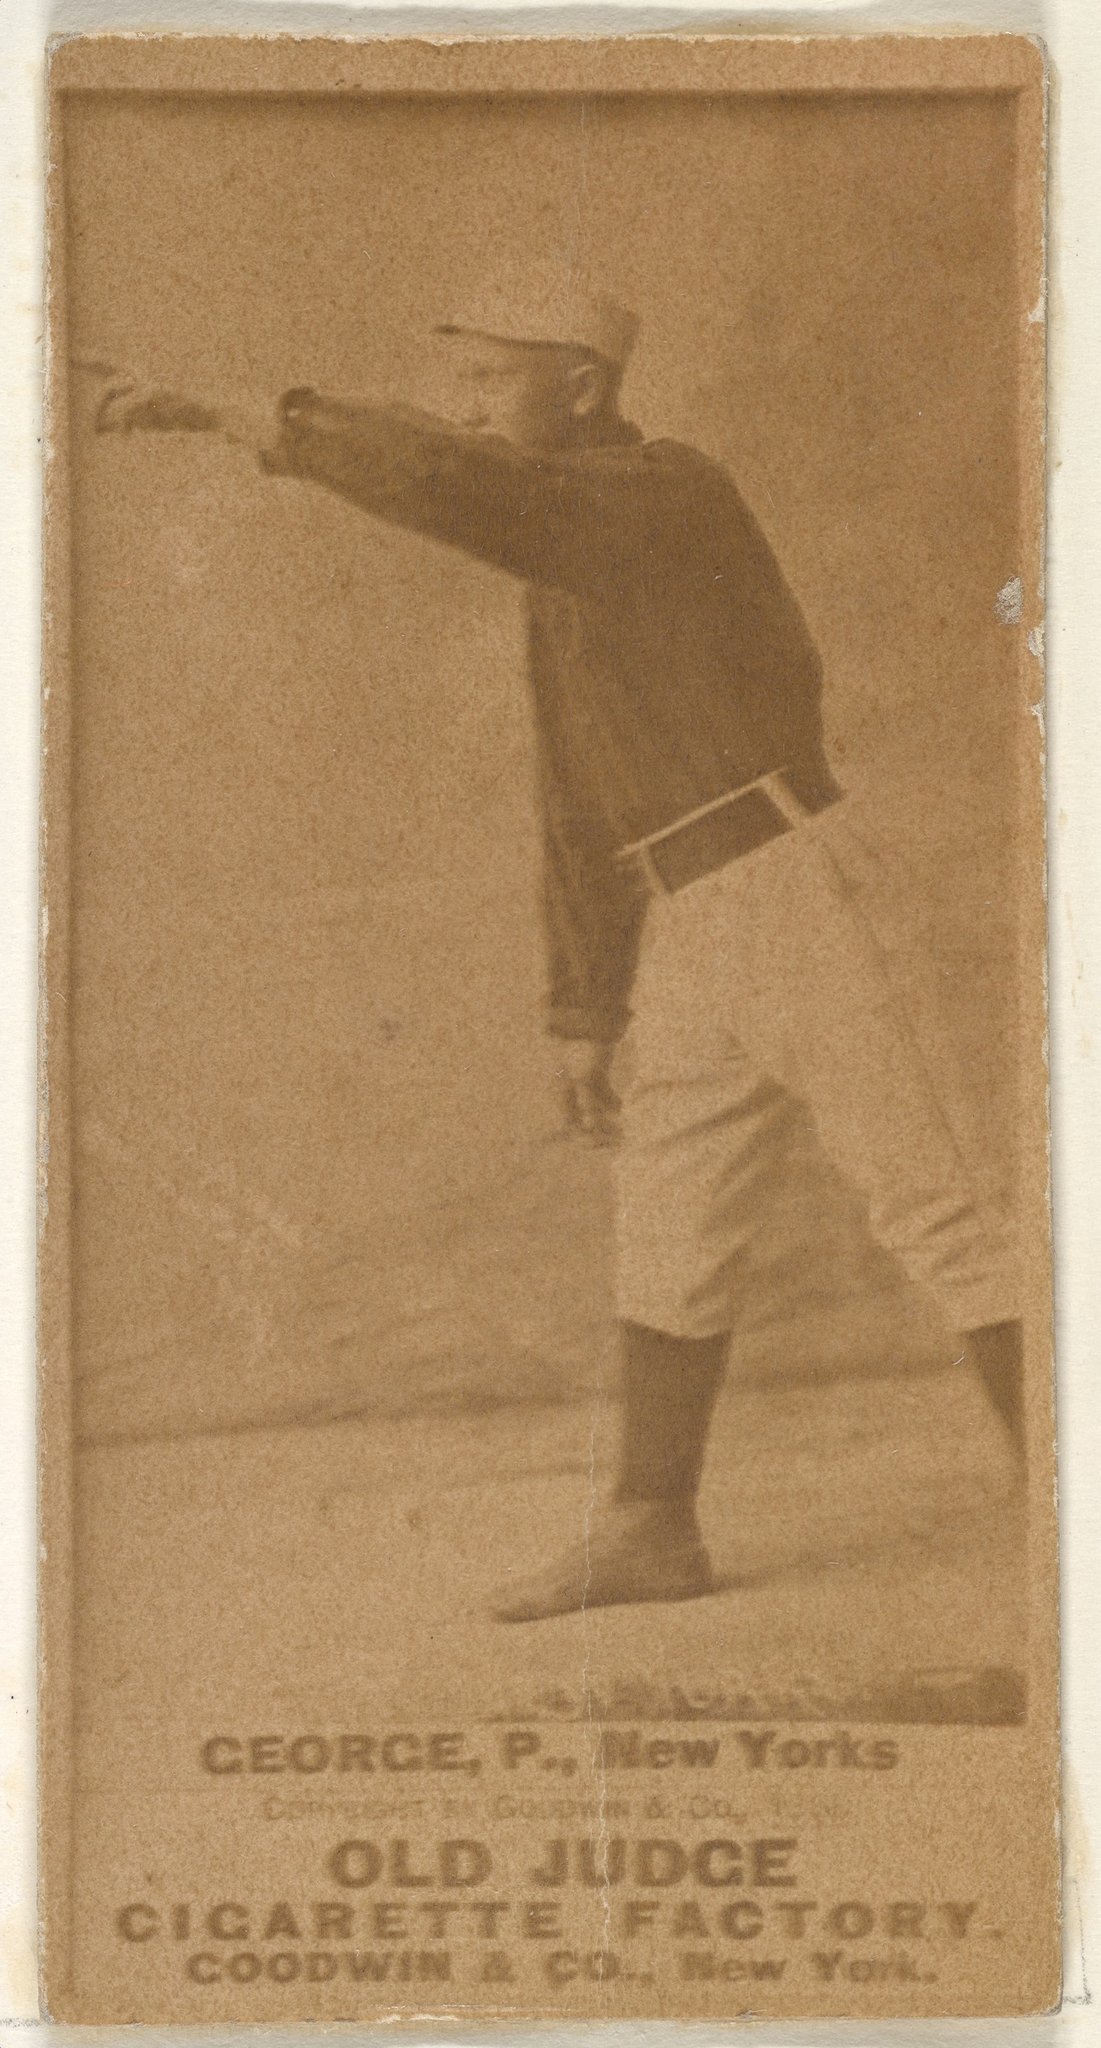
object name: baseball card, photograph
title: Bill George, Pitcher, New York, from the Old Judge series (N172) for Old Judge Cigarettes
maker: goodwin & company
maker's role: publisher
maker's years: 1850-1950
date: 1887-1890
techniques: albumen silver print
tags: men,portraits,baseball,athletes